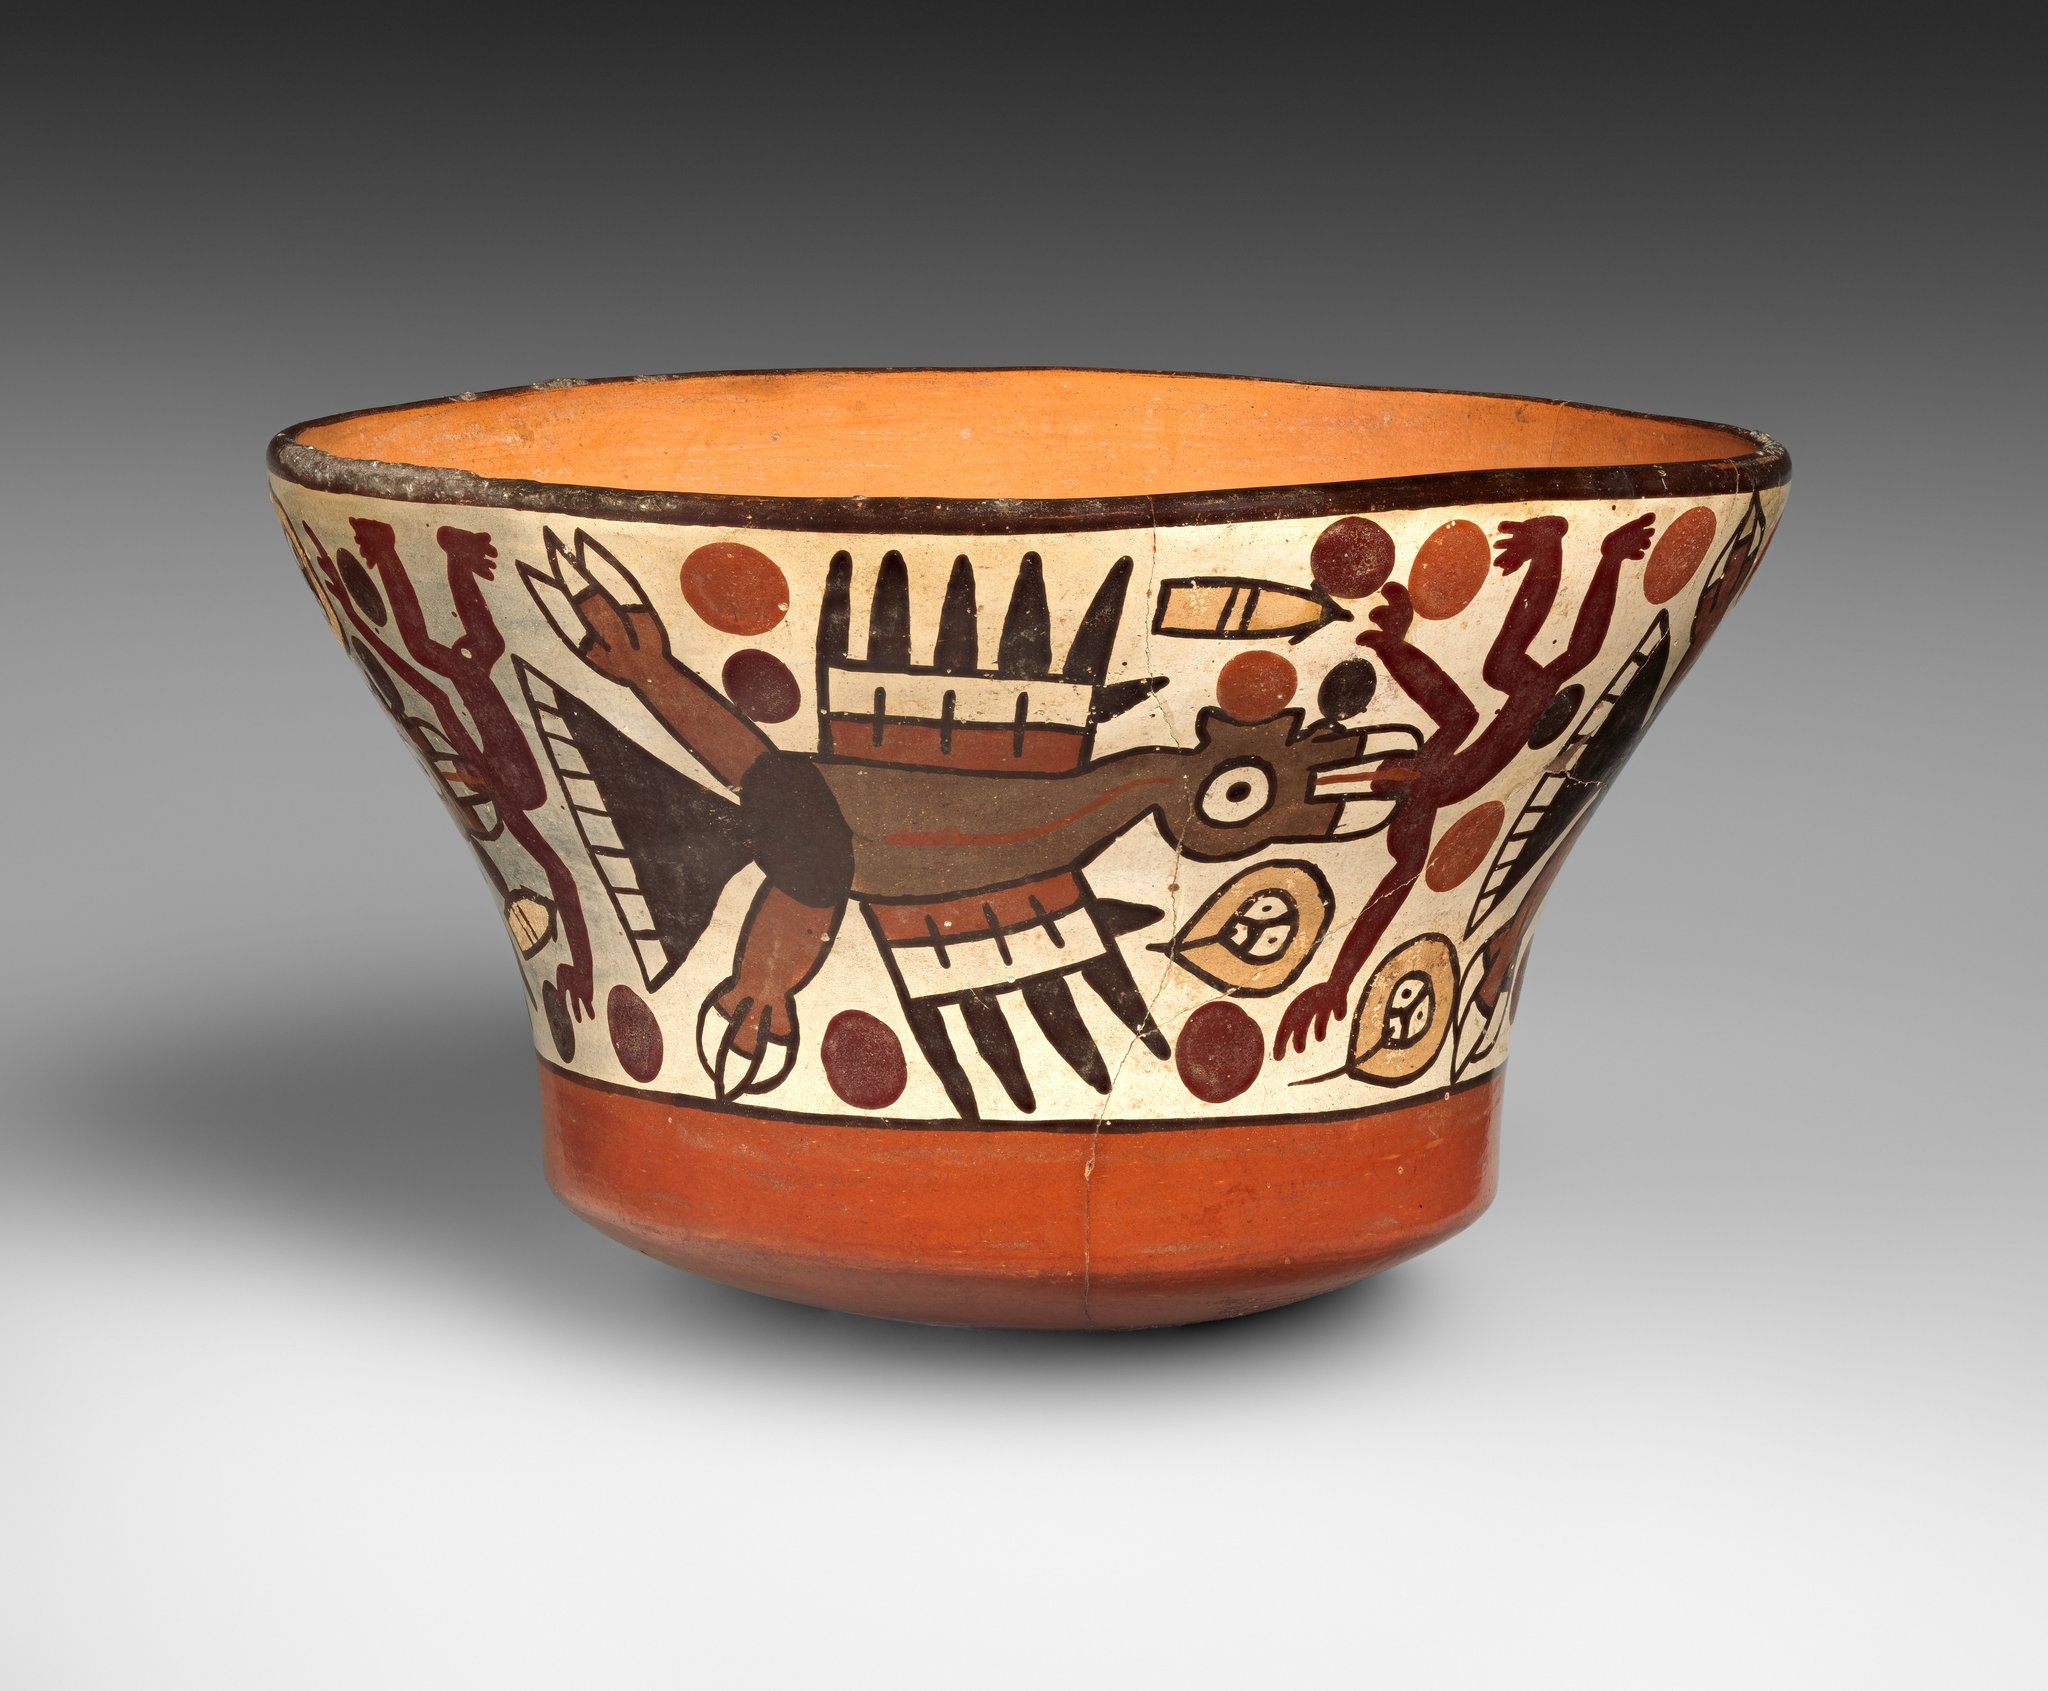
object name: bowl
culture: nasca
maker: nasca artist(s)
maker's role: artist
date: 1-400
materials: ceramic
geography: peru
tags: birds